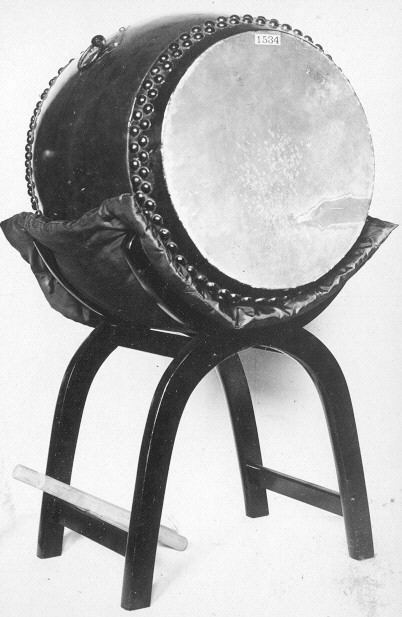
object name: o daiko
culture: japanese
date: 1801-1900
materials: skin, wood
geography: japan